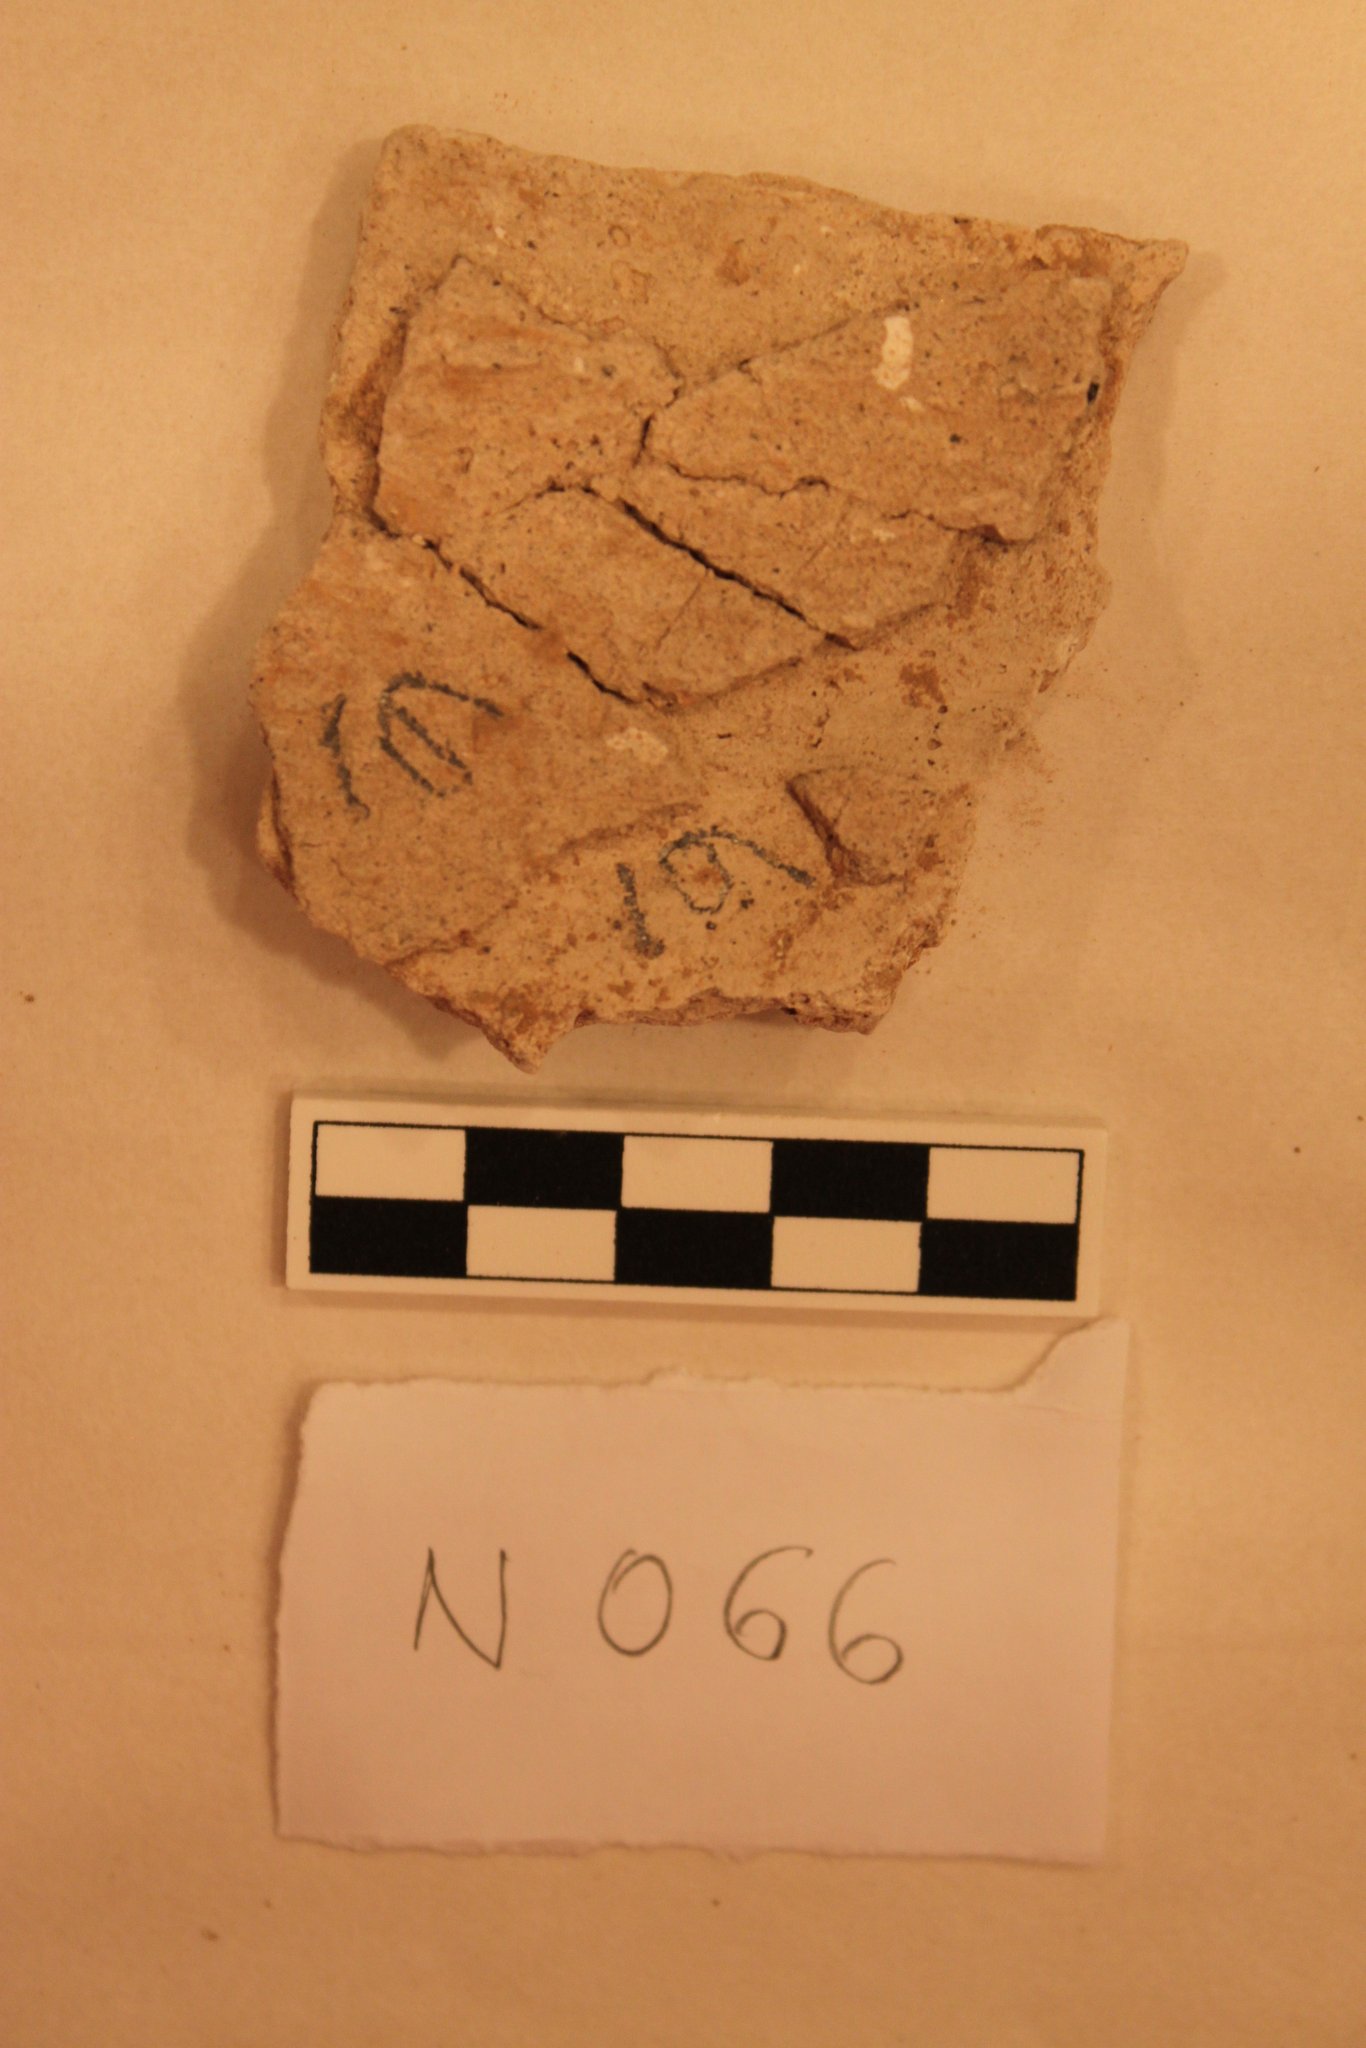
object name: fragment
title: Stucco Fragment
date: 701-1200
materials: plaster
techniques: carving, painting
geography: iran